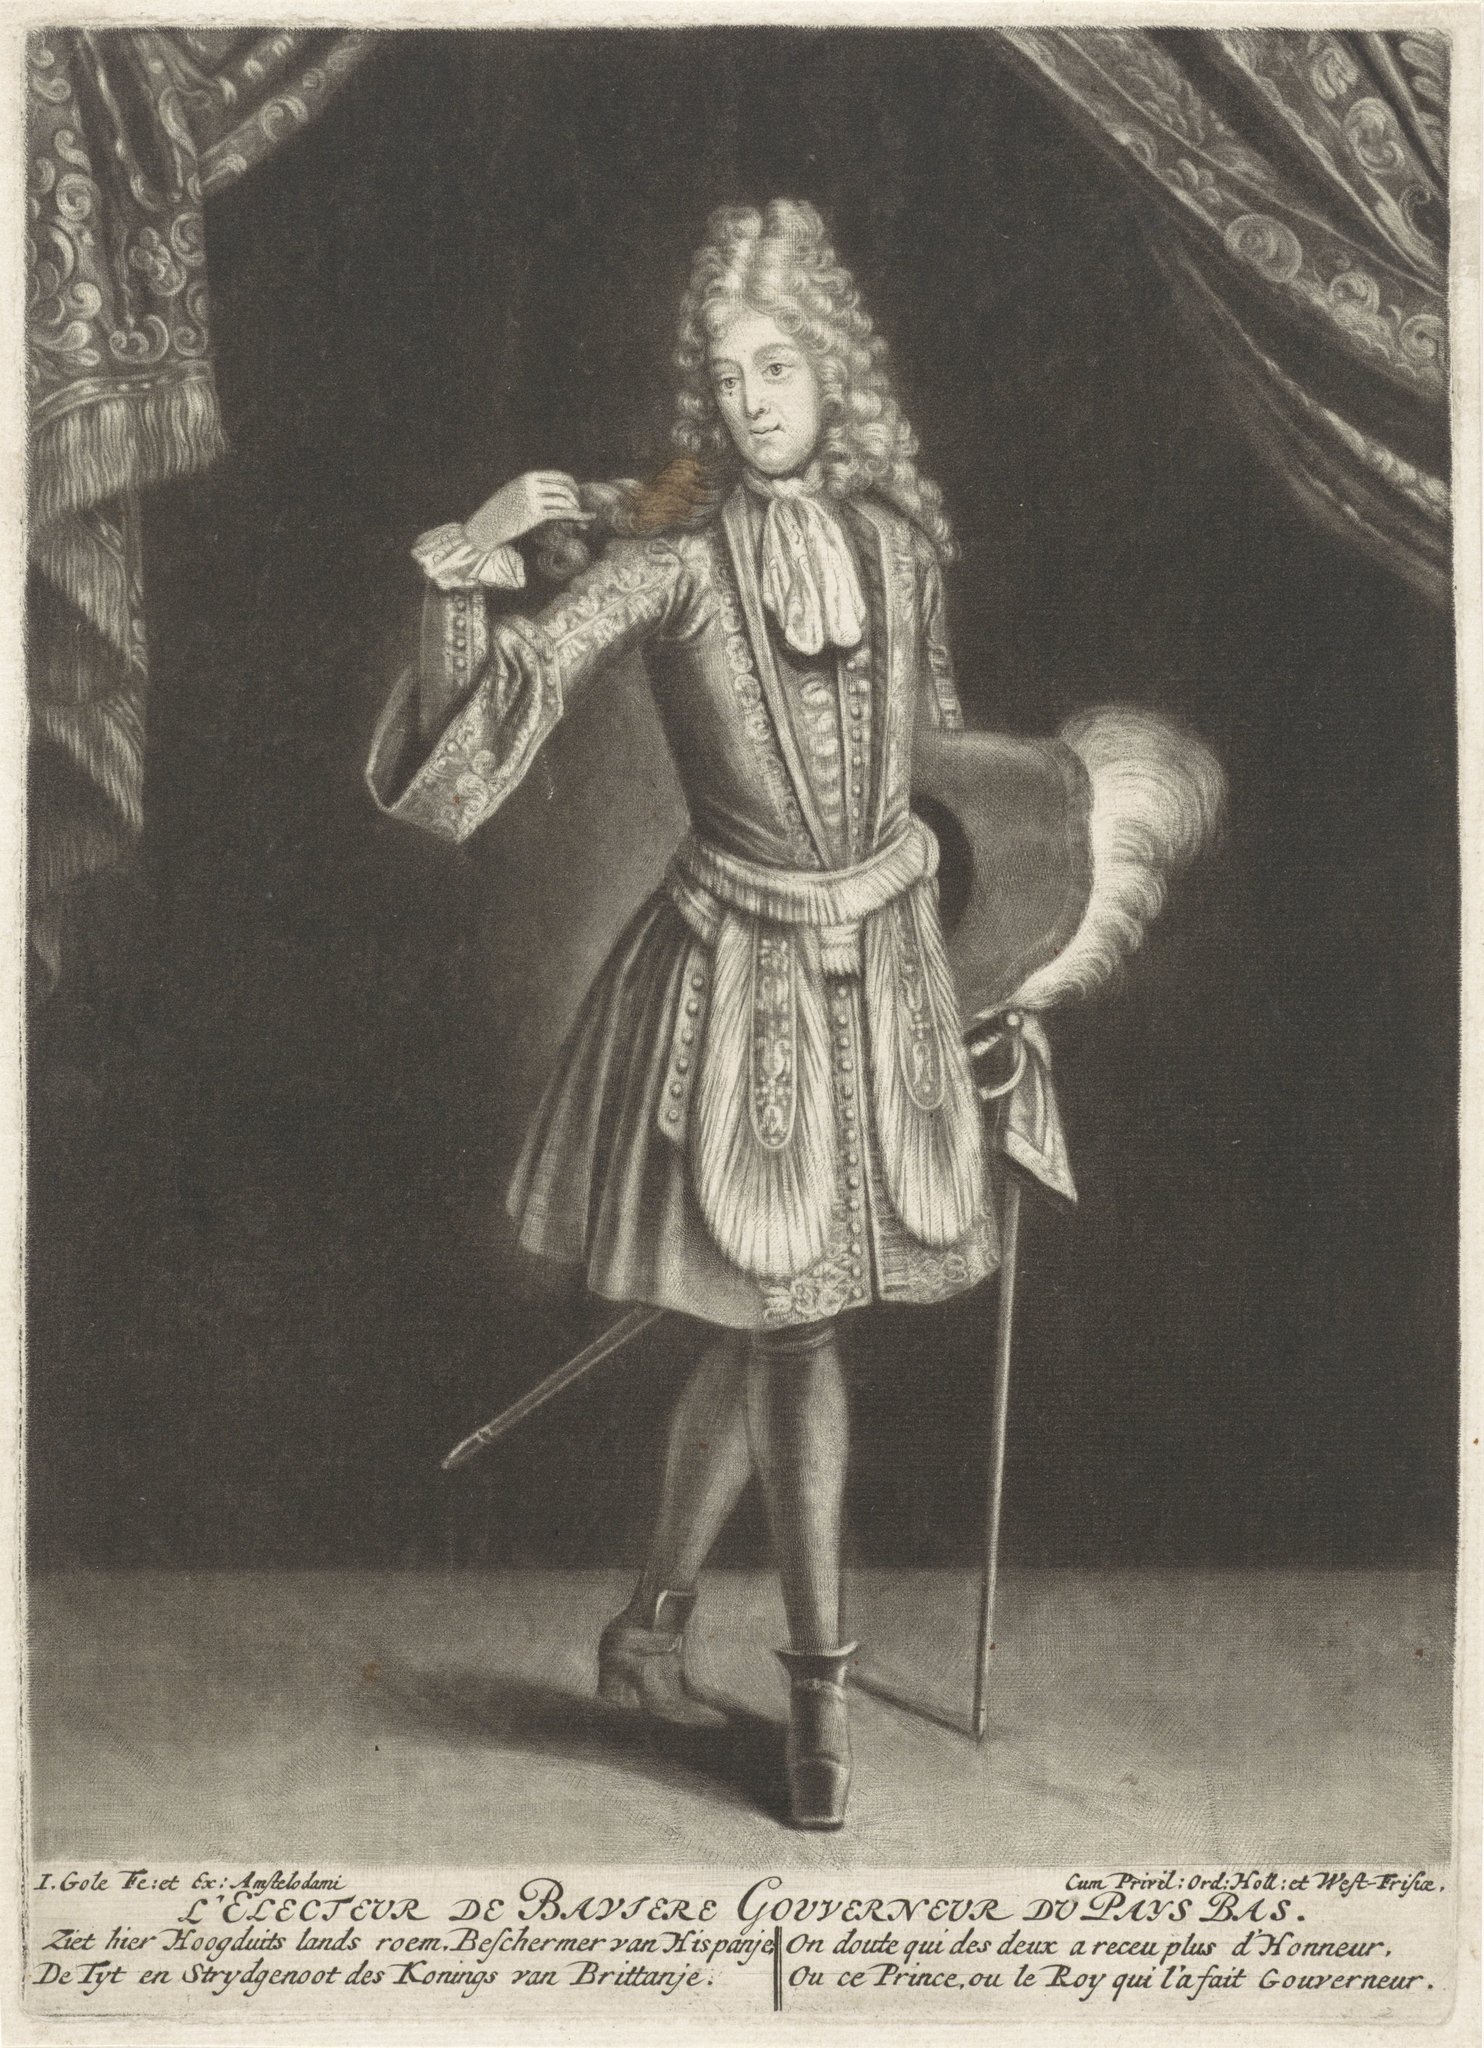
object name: print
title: Portret van Maximiliaan Emanuel II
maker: jacob gole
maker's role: print maker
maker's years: 1660-1724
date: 1672-1724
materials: paper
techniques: engraving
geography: amsterdam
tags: maximiliaan ii emanuel (keurvorst van beieren)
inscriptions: collector's mark: Lugt 964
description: Maximiliaan Emanuel II, keurvorst van Beieren en landvoogd van de Zuidelijke Nederlanden.